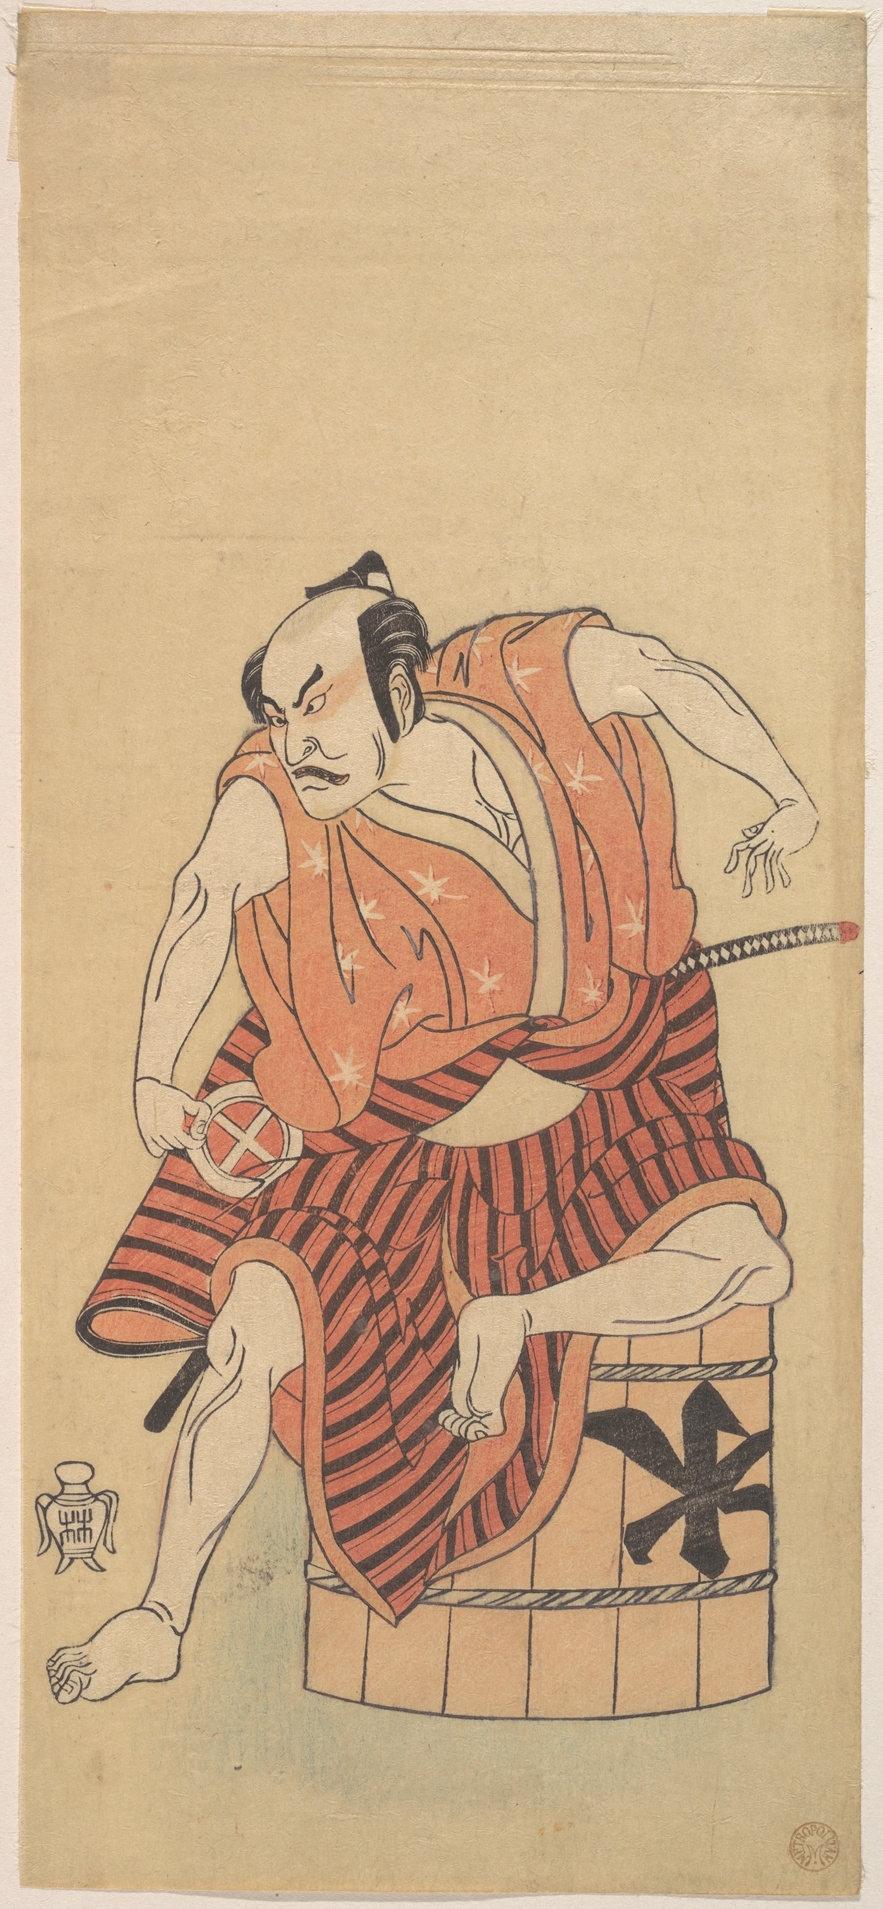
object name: woodblock print nishiki e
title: The Third Otani Hiroemon as an Otokodate Seated Upon an Inverted Tub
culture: japanese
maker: katsukawa shunshō 勝川春章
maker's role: artist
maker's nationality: japanese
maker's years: 1726-1792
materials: ink, paper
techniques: nishiki e, woodblock print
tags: men,actors